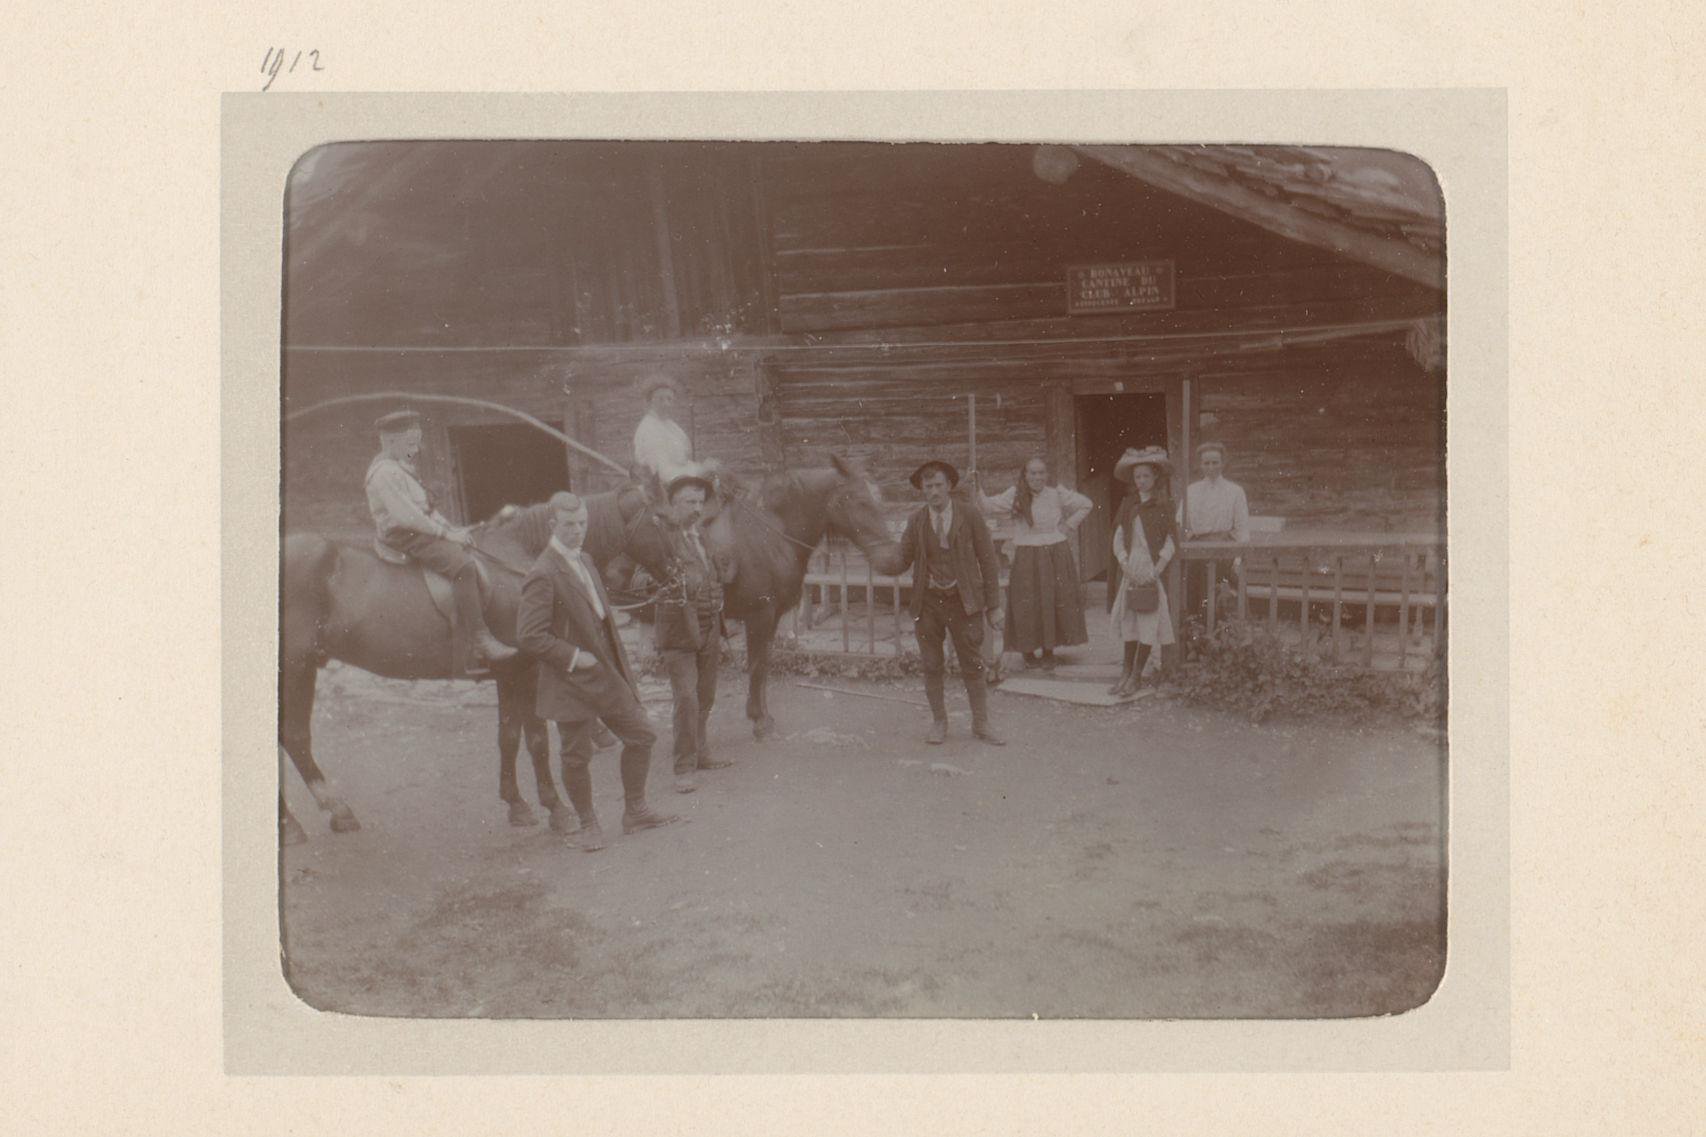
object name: album leaf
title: Groepsportret tijdens een rit te paard door de bergen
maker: liesbeth overhoff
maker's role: fotograaf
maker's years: 1895-1969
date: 1912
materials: paper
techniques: gelatin silver print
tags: riding a horse, ass, or mule; rider, horseman, historical persons, mountains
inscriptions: inscription: ‘1912’